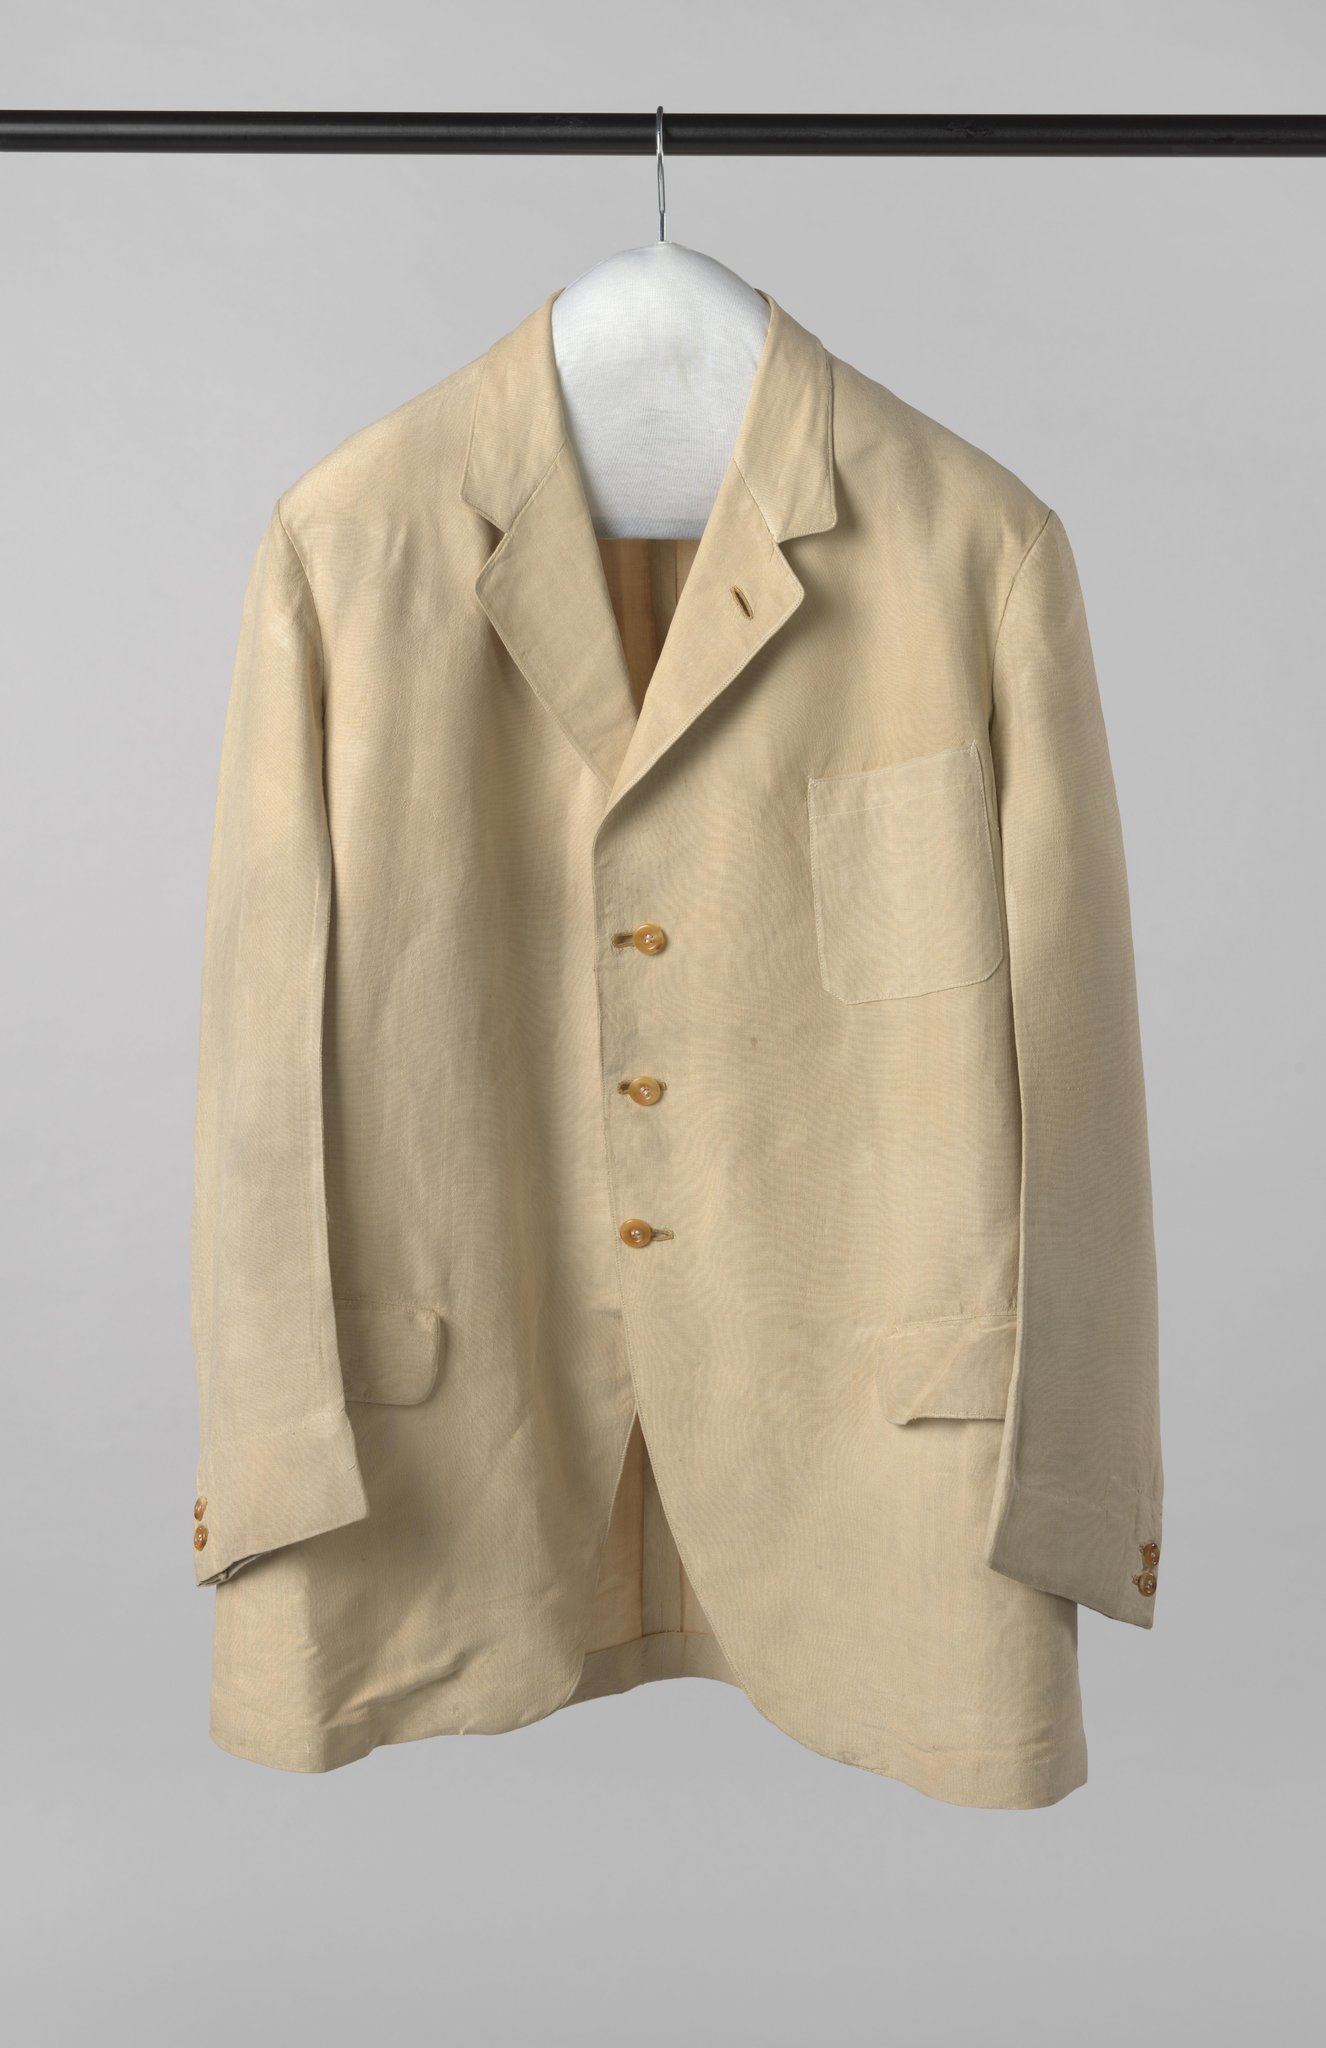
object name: menswear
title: Licht getailleerde jas van beige katoen, met benen knopen, kleine smalle revers, twee heupzakken met klep, horizontaale vastgenaaide rugband en opgenaaide zak linksboven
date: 1925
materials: cotton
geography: london